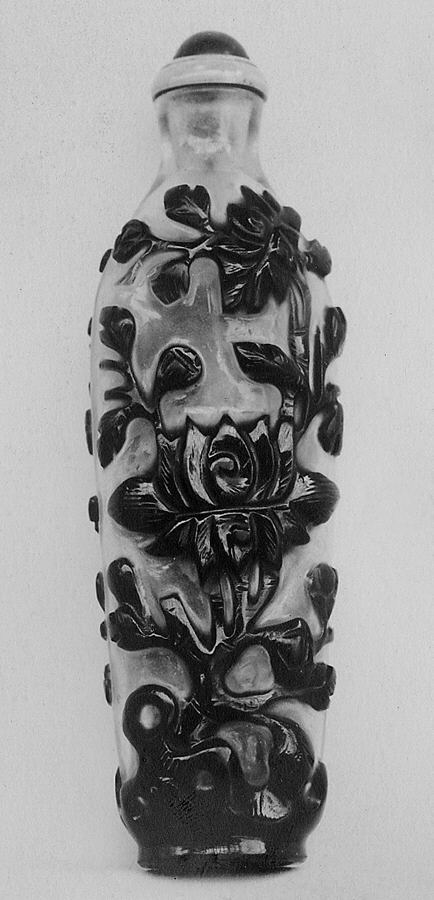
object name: snuff bottle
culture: chinese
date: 1736-1795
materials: glass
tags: flowers